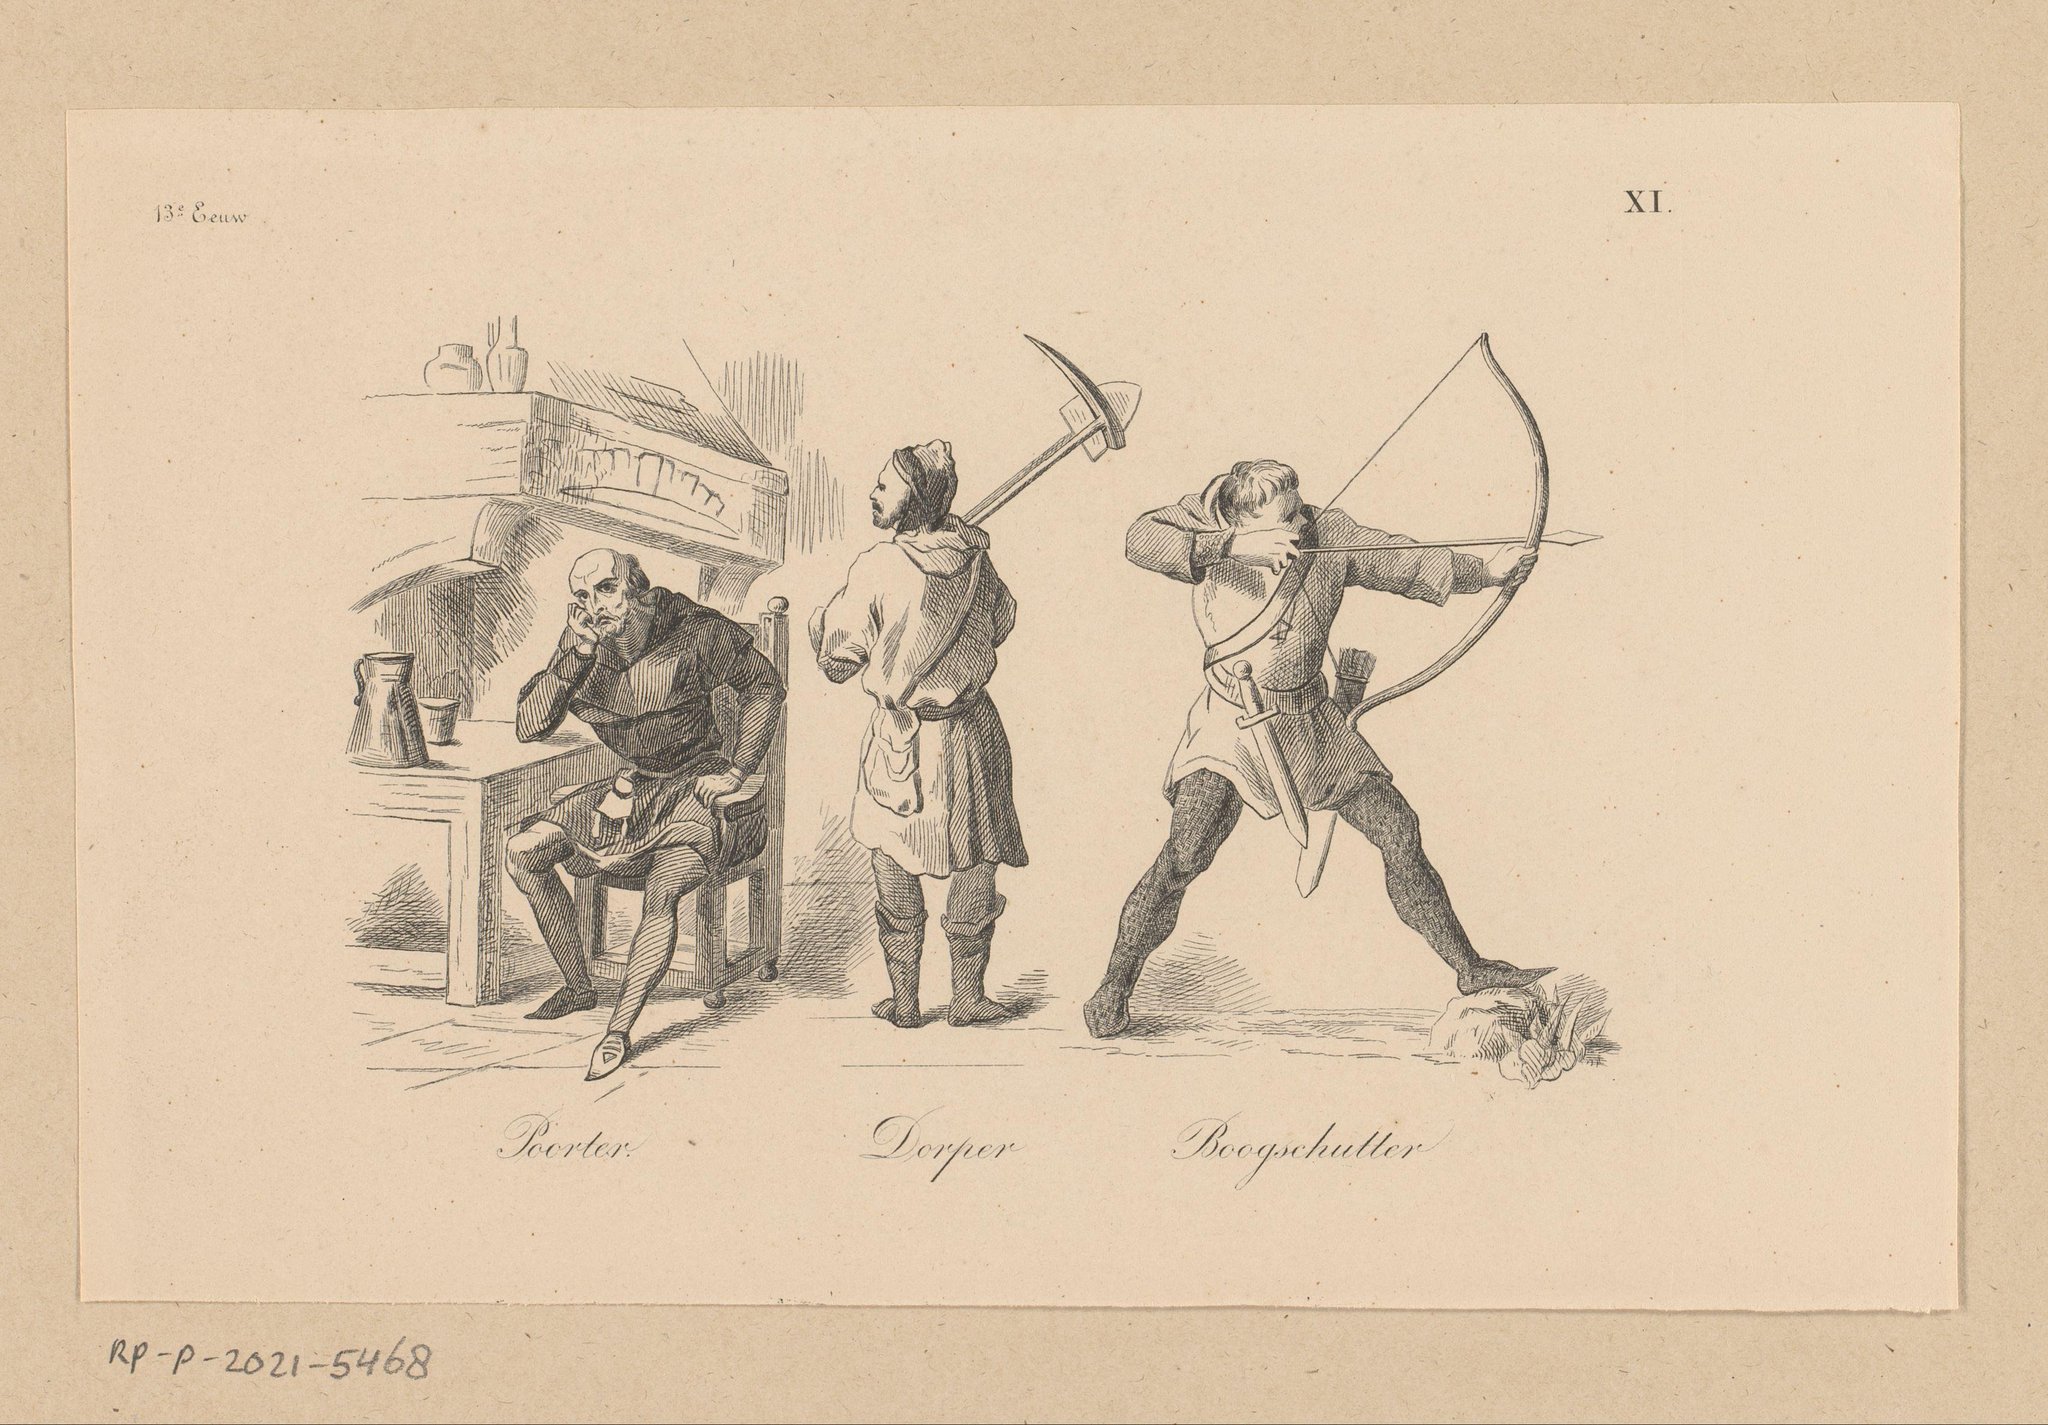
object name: costume print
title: Poorter / Dorper / Boogschutter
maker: Anonymous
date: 1857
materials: paper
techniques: lithograph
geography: netherlands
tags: open hearth, fire-place, archer's weapons, clothes, costume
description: Prent waarschijnlijk uit: Hofdijk, Willem Jacob. Schets van de geschiedenis der Nederlanden. Amsterdam: Gebroeders Binger, 1857.